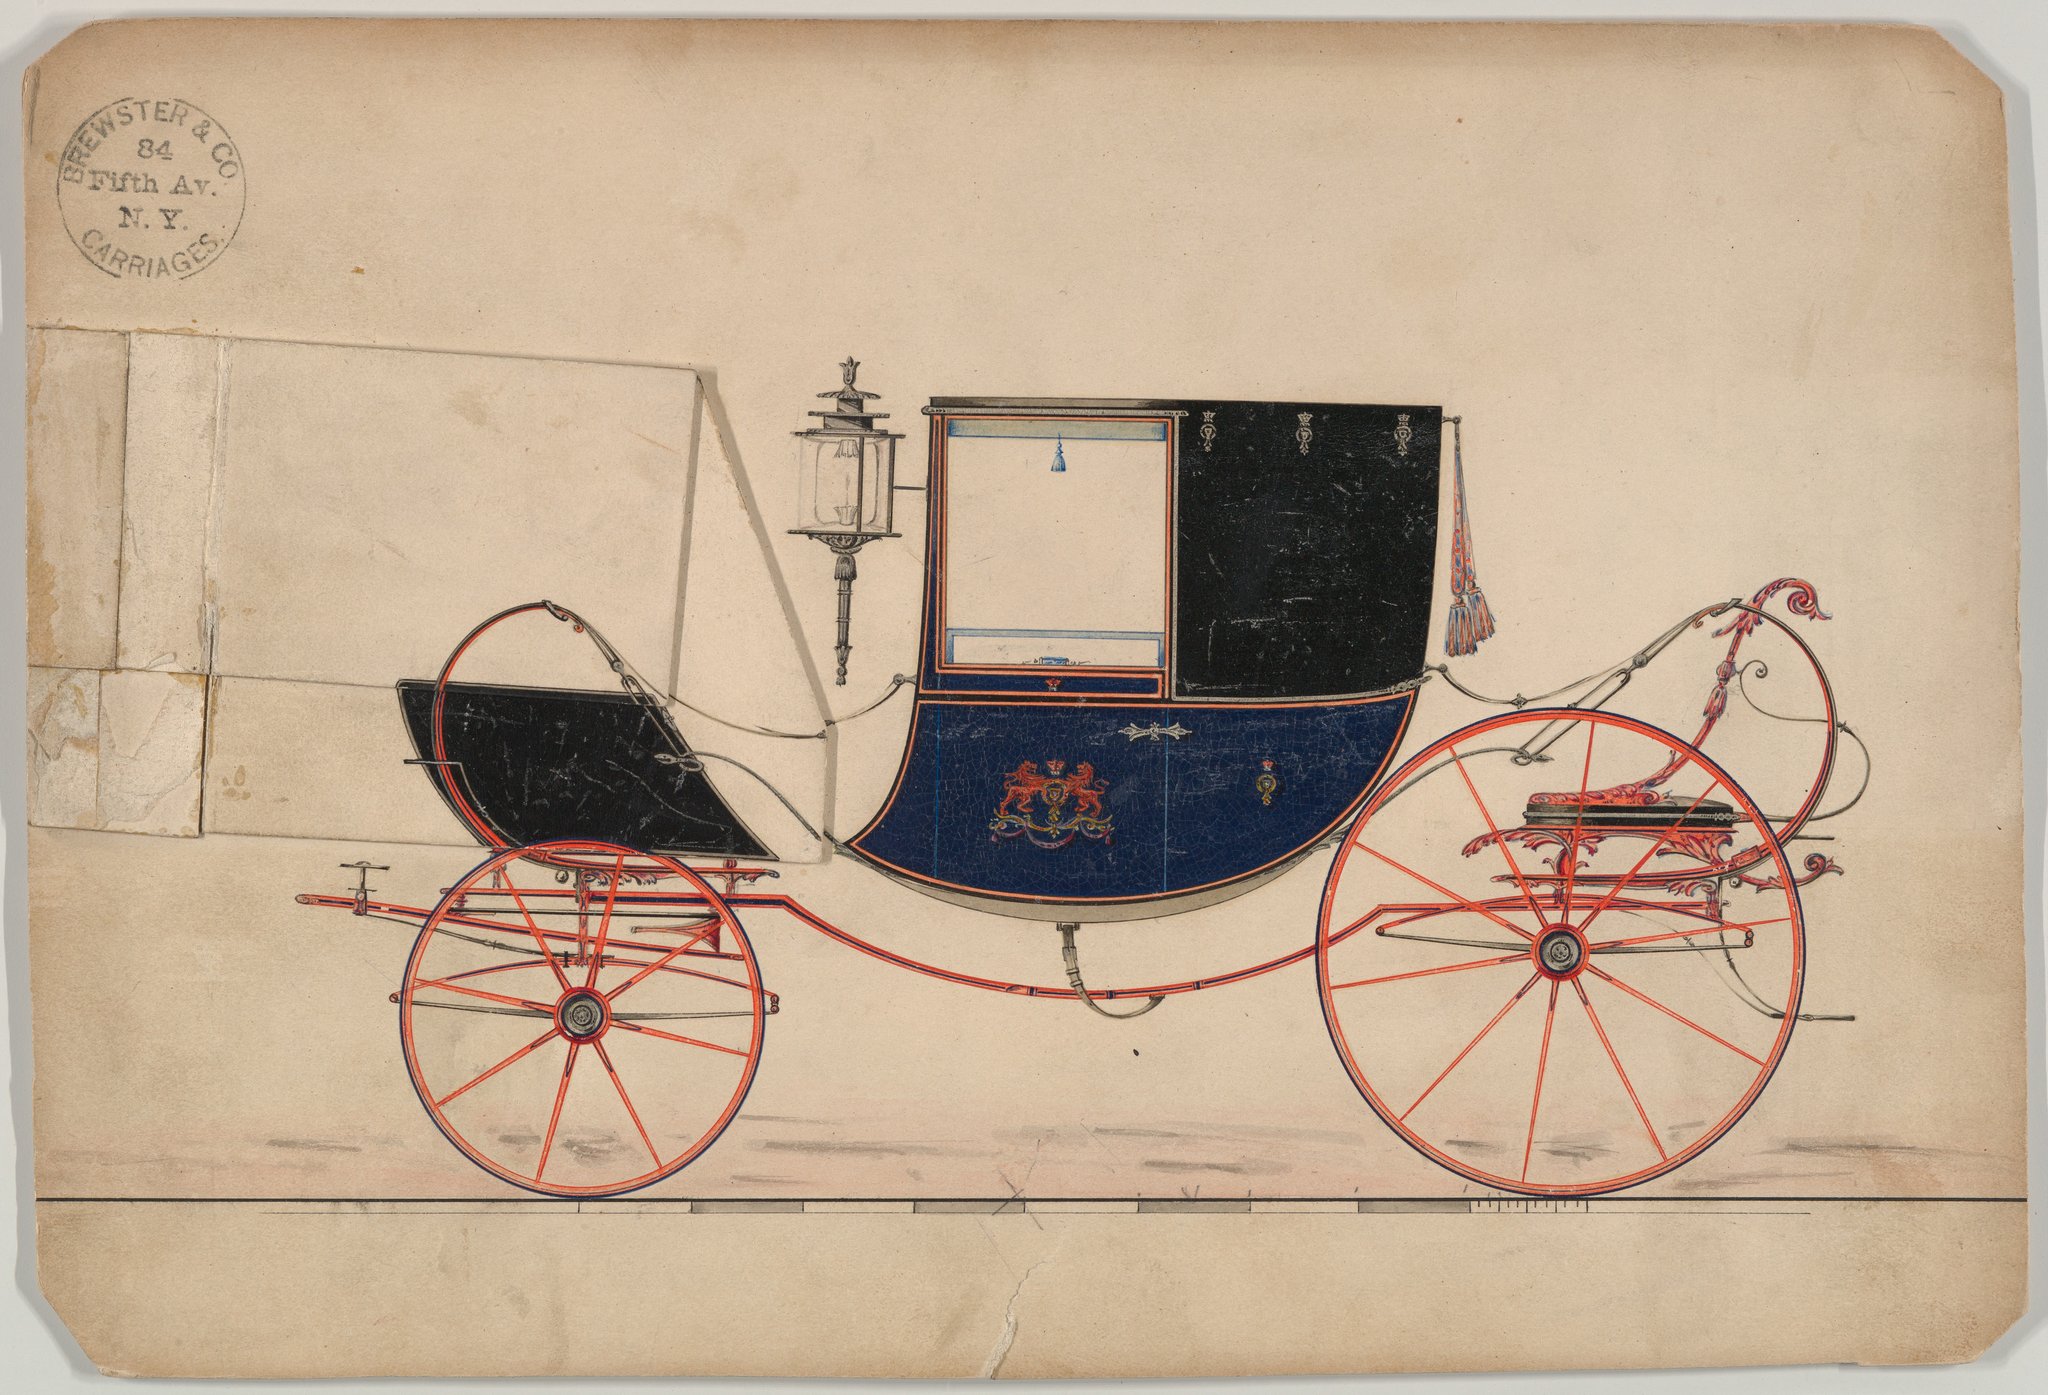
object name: drawing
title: Dress Chariot (unnumbered)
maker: brewster & co.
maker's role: manufacturer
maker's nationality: american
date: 1850-1870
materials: gouache, gum arabic, ink, silver, watercolor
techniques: pen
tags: carriages